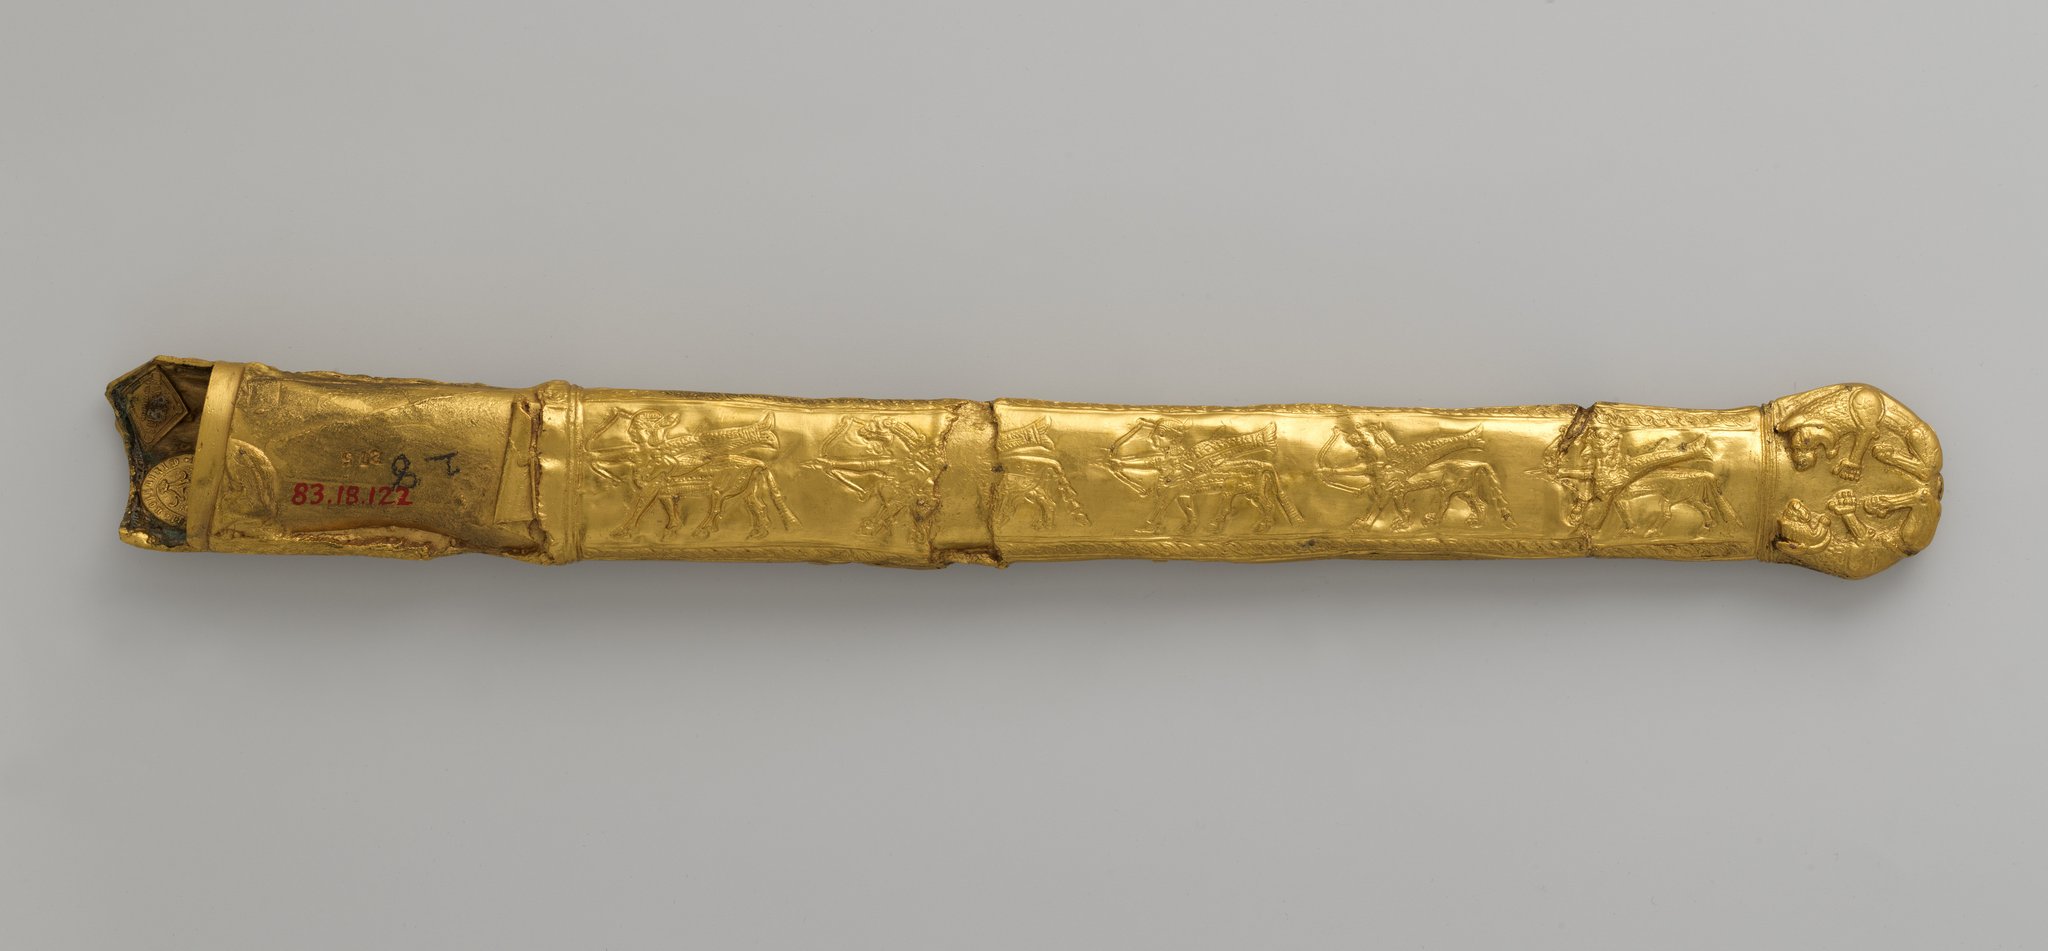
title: Reproduction of a Scythian sword sheath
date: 1801-1900